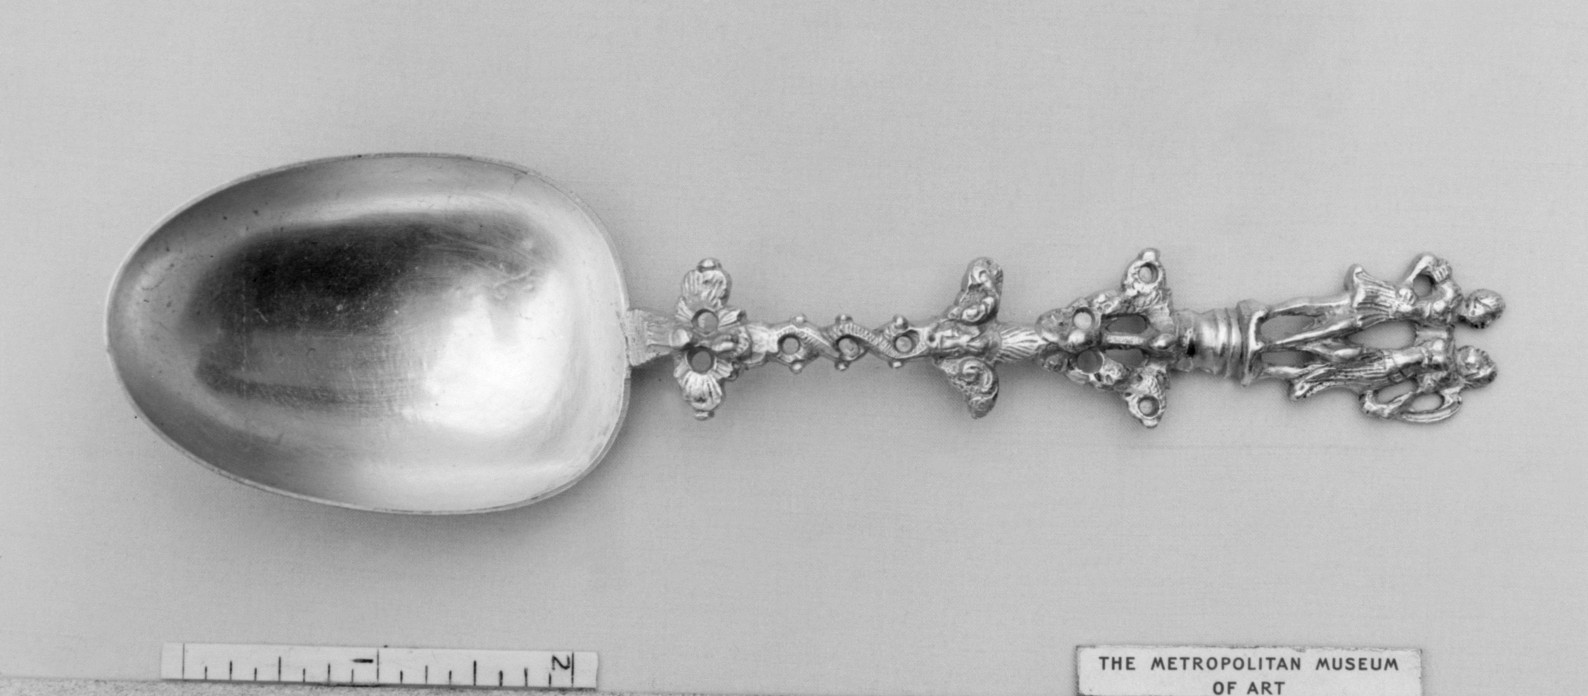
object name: spoon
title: Figure-top spoon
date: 1767-1800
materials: silver